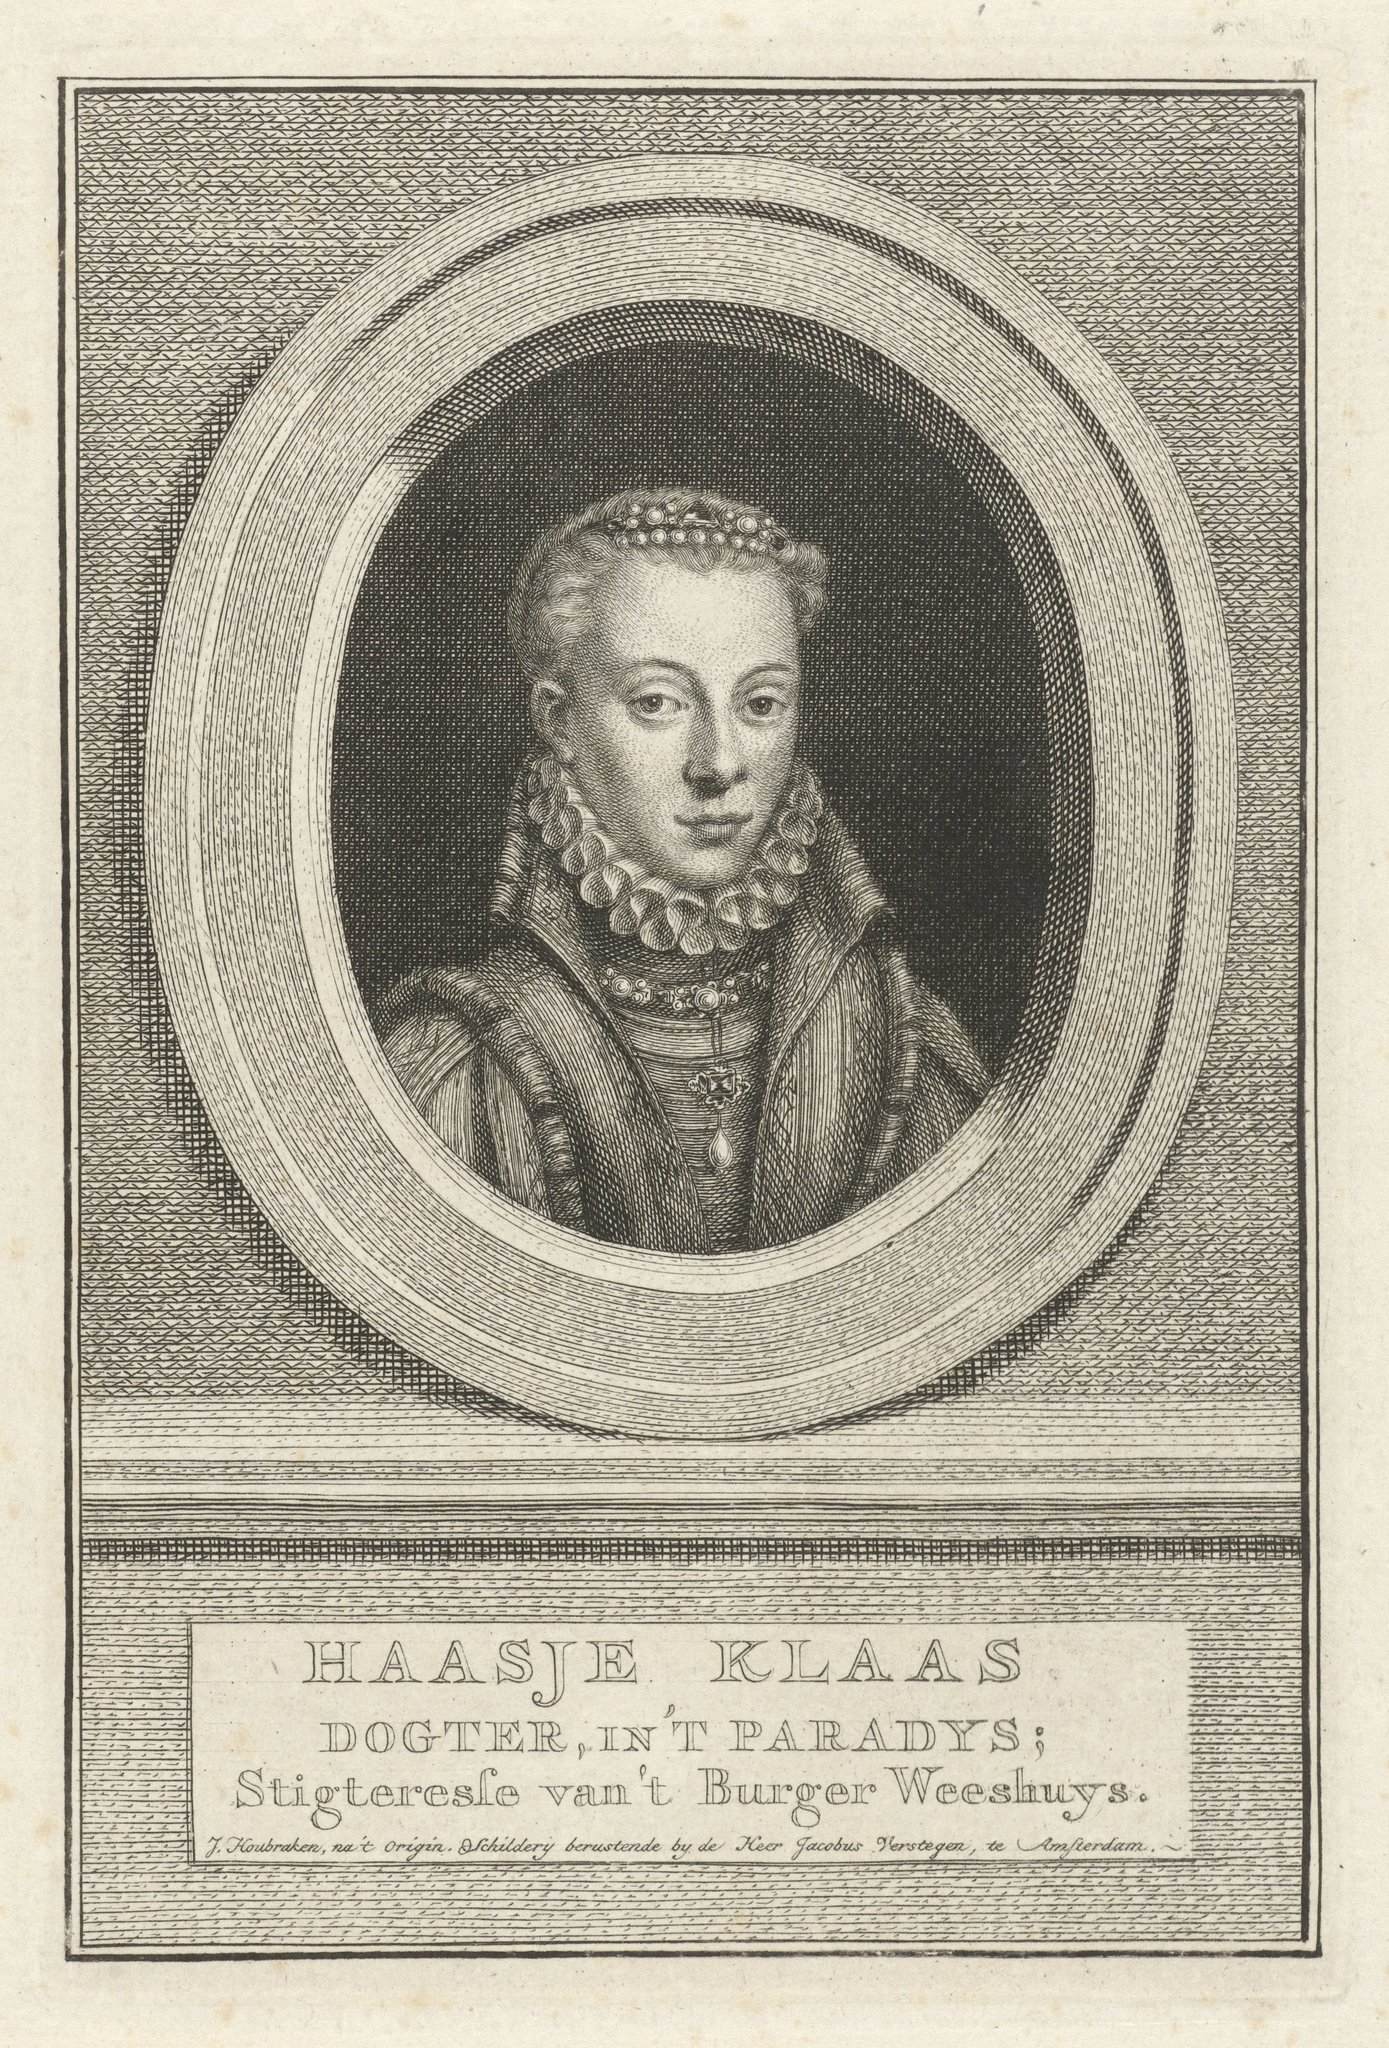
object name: print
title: Portret van Haasje Klaas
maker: jacob houbraken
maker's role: draughtsman, print maker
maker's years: 1698-1780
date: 1708-1780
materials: paper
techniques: engraving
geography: amsterdam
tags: haasje klaas, burgerweeshuis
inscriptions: collector's mark: Lugt 2228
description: Buste van Haasje Klaas in een ovaal. Het portret rust op een plint waarop haar naam en gegevens in drie regels in het Nederlands.